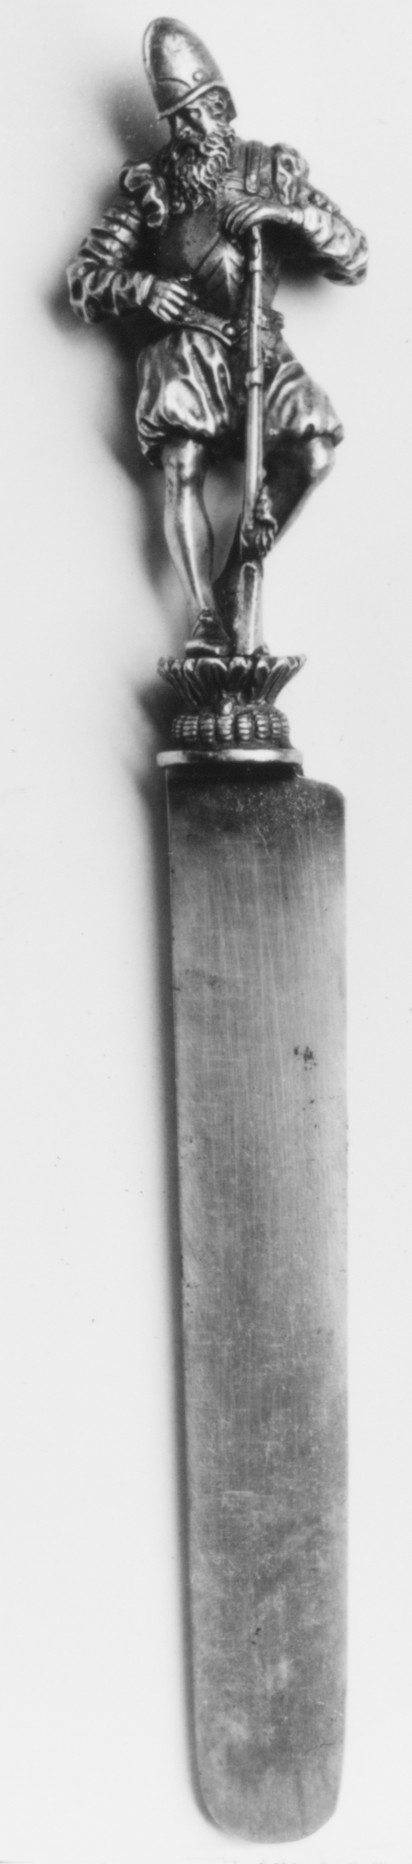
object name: knife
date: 1801-1900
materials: silver gilt, steel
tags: knives,men